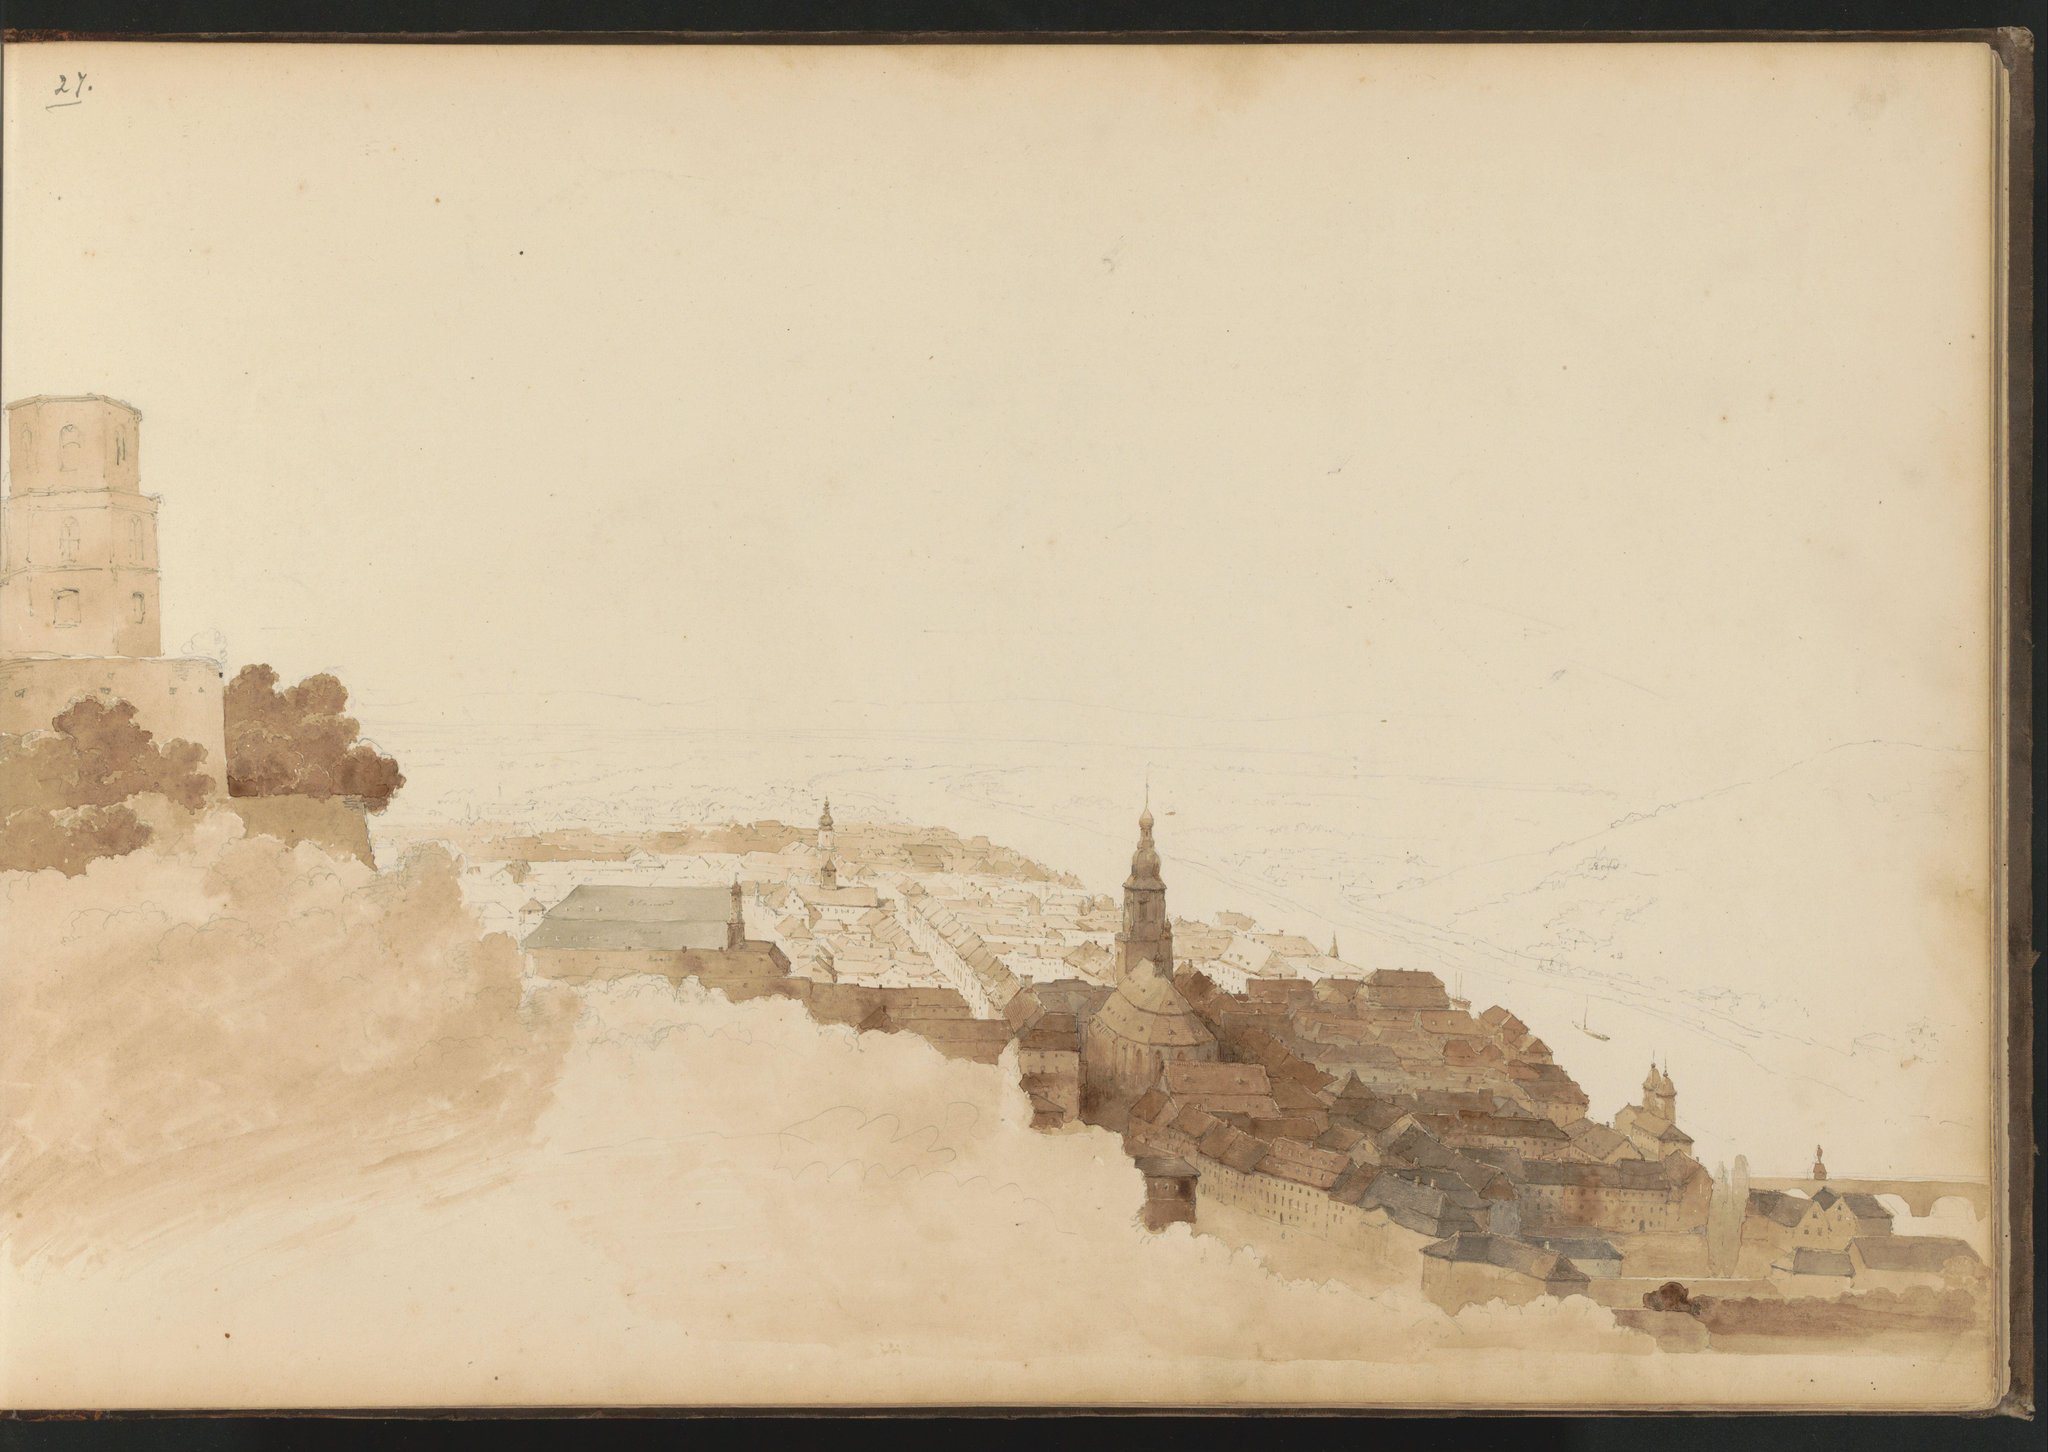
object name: sketchbook leaf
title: Gezicht op Heidelberg vanaf Schloss Heidelberg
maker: kasparus karsen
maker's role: draughtsman, painter, print maker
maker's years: 1810-1896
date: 1820-1896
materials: paper, pencil, watercolor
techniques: brush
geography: heidelberg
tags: city-view, and landscape with man-made constructions, church (exterior)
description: Gezicht op het oude centrum met de kathedraal. Blad 27 recto uit een schetsboek met 68 bladen.